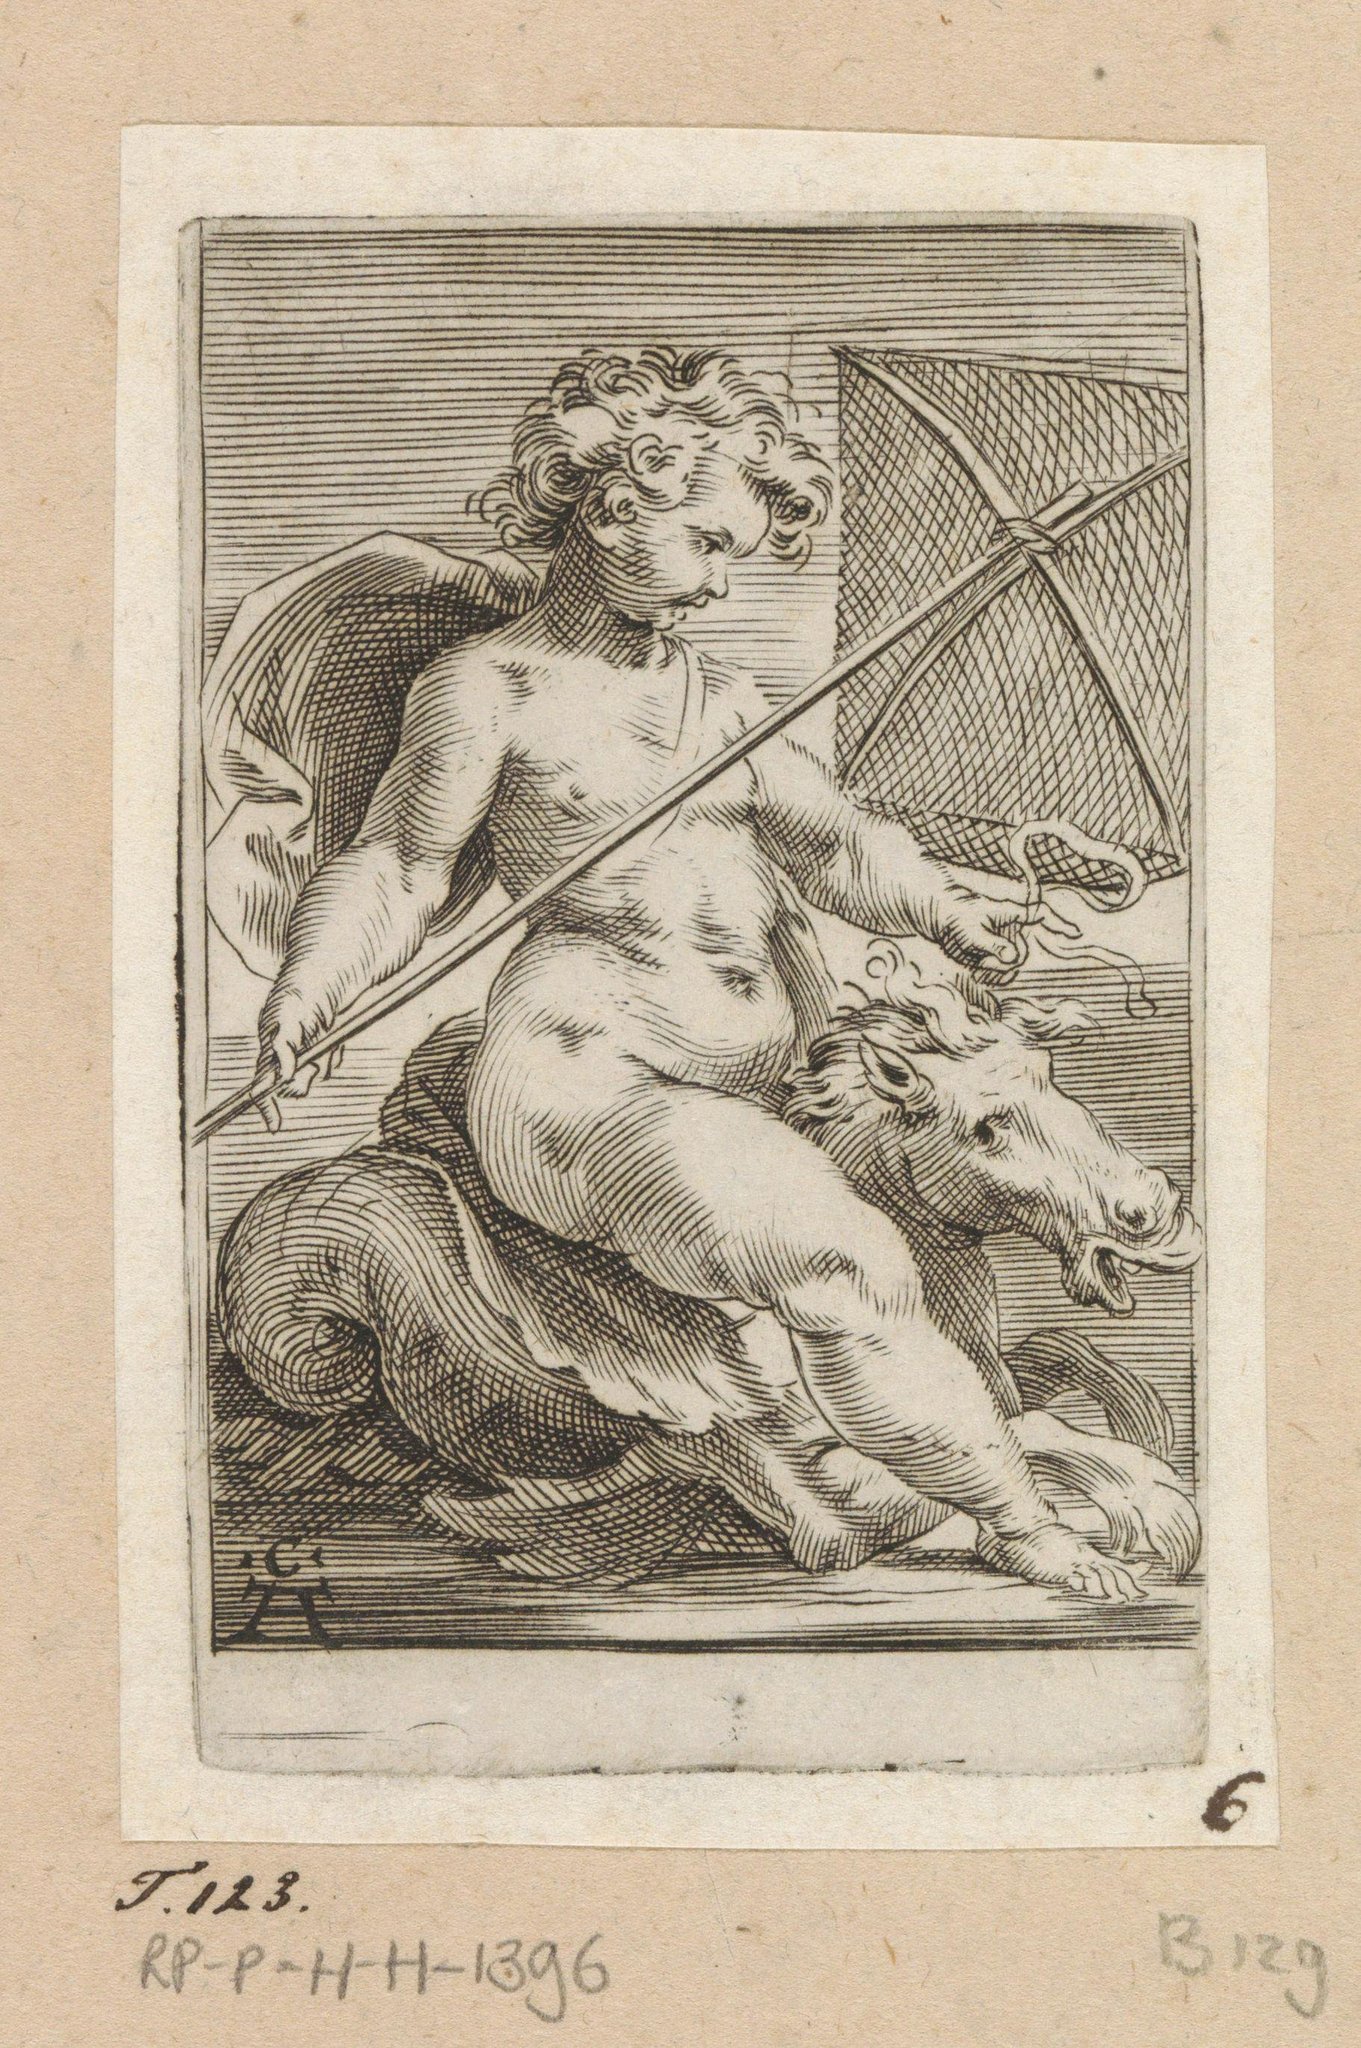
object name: print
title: Putto op een zeepaard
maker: cherubino alberti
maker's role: draughtsman, print maker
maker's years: 1553-1615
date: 1563-1615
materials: paper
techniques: engraving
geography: italy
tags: sea-horse, hippocamp, 'hippocampus', (horse/fish) (mythological hybrid monster), fishing net, cupids: 'amores', 'amoretti', 'putti'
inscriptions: number: ‘6’, collector's mark: ‘Hinloopen’, collector's mark: Lugt 11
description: Onbeschreven latere staat van deze prent waarbij het windijzer is veranderd in een visnet.